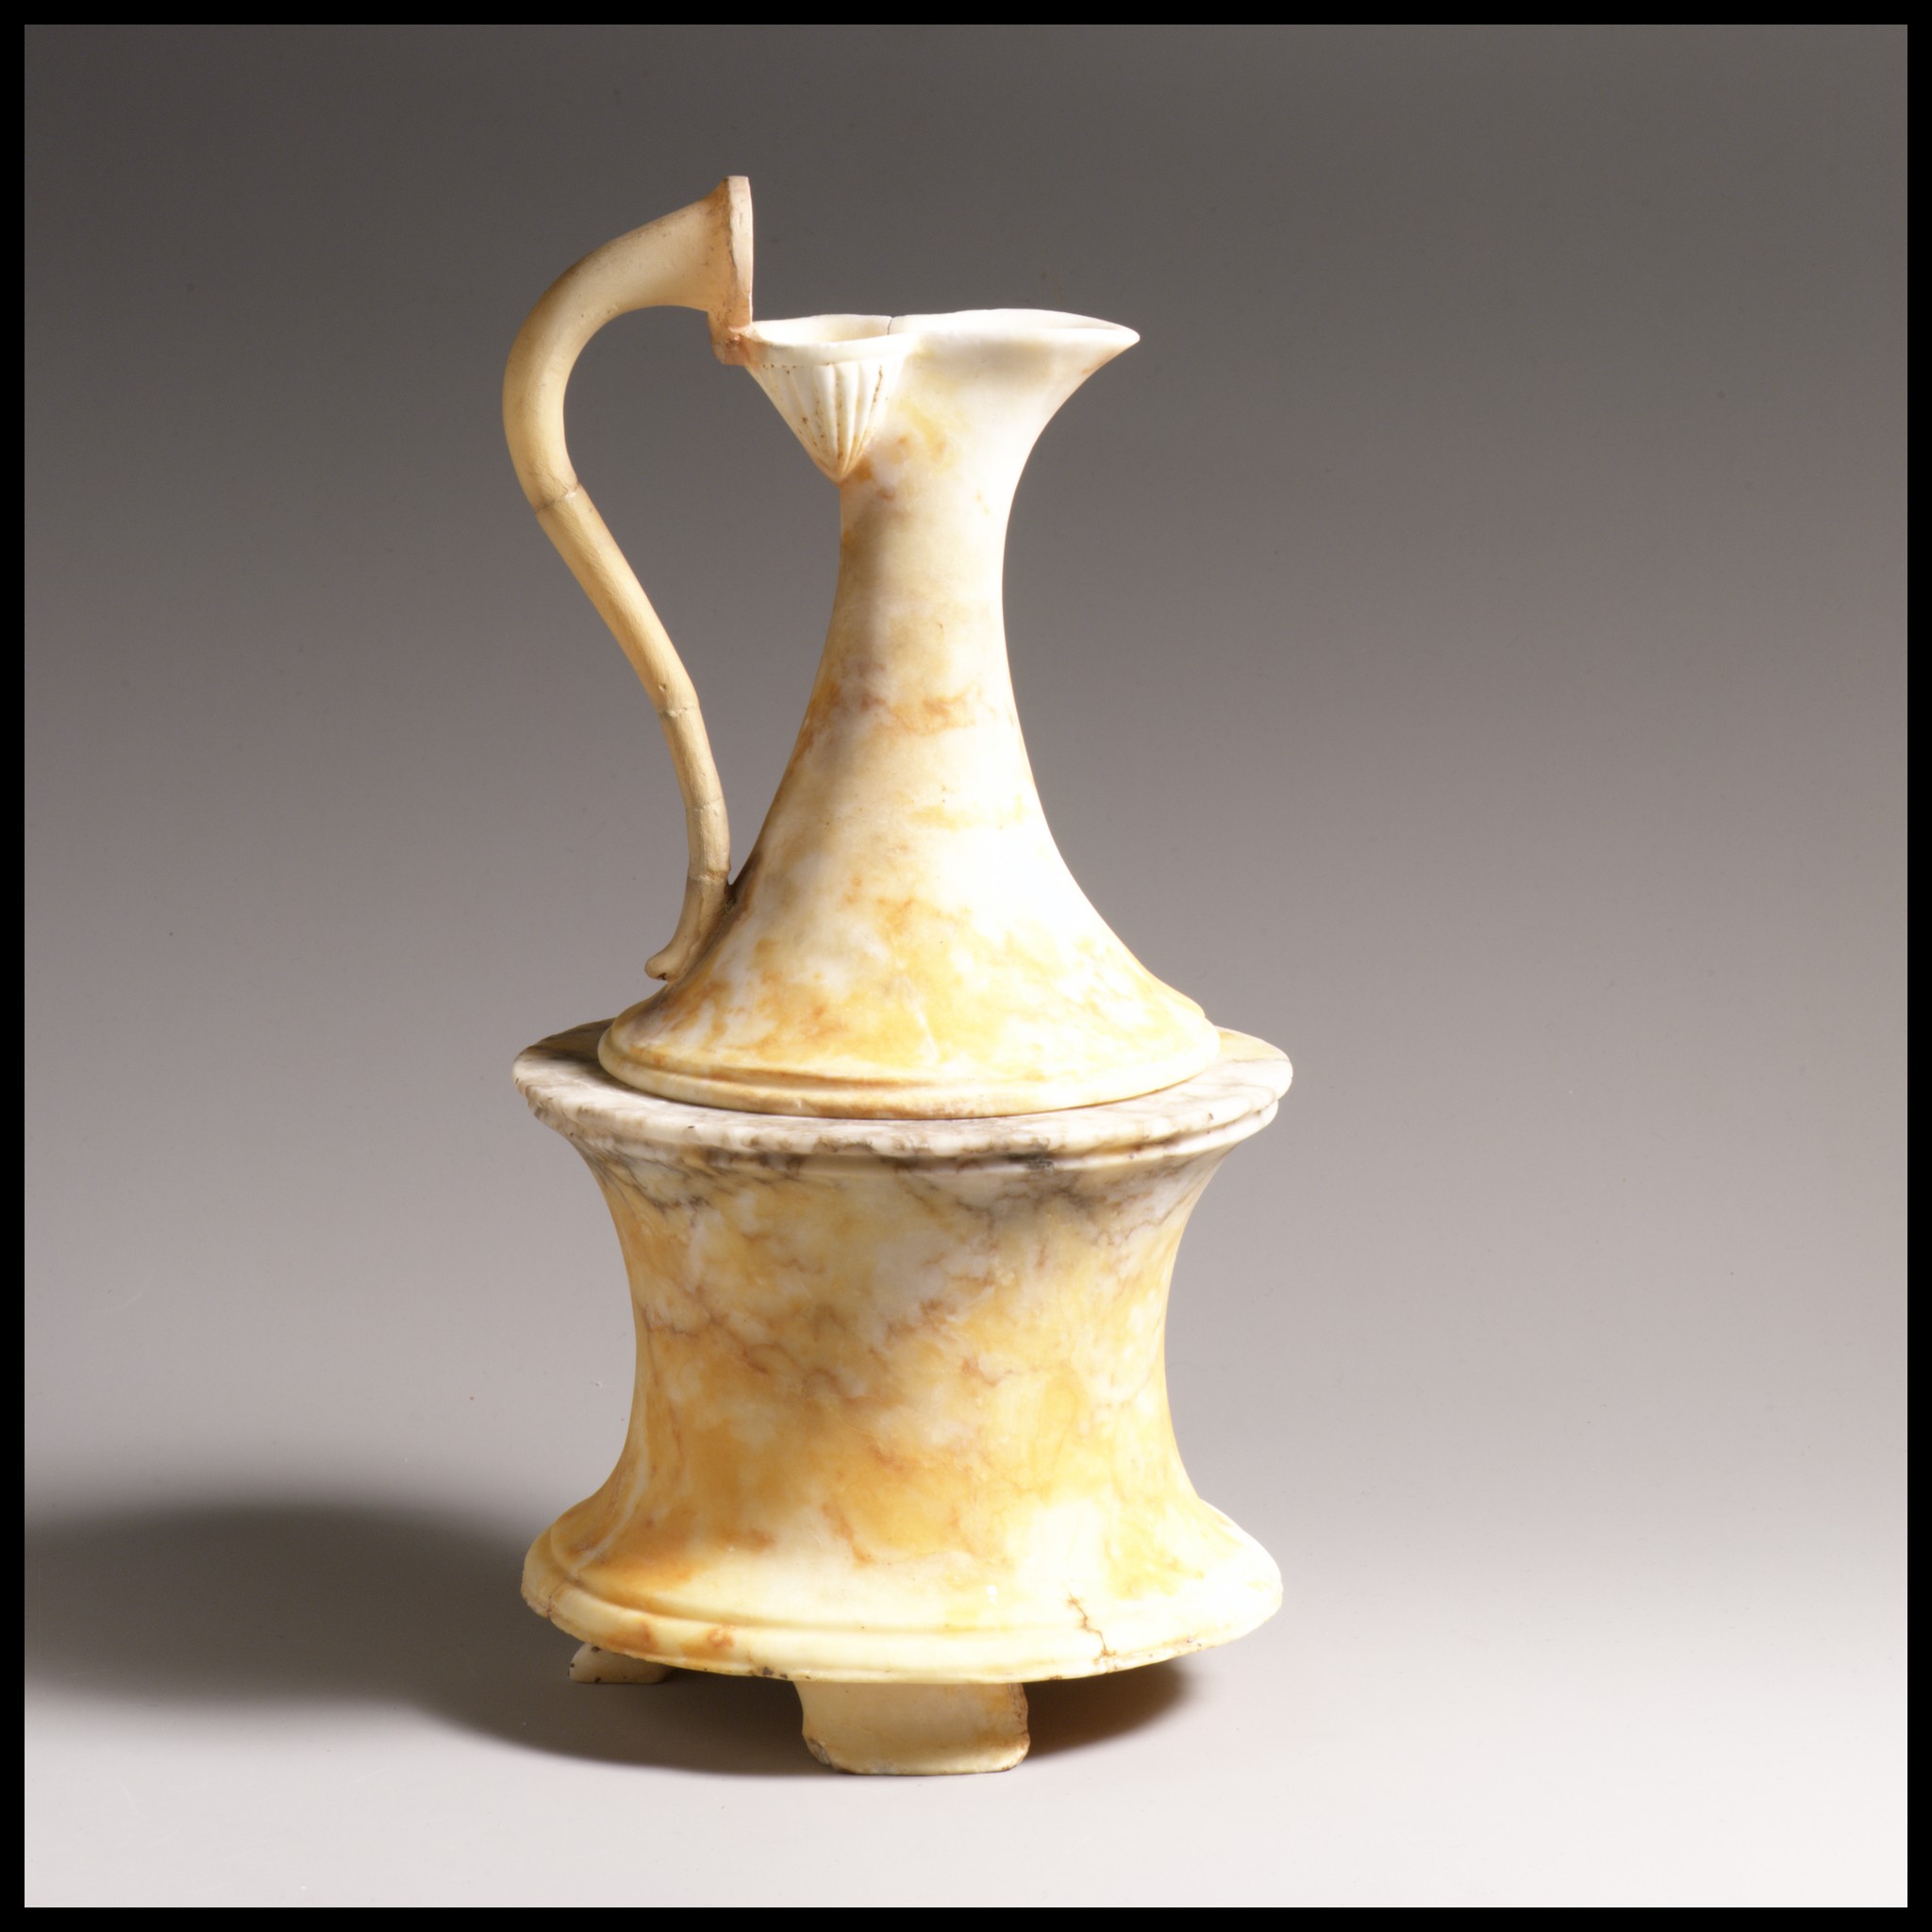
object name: vase in the form of a pyxis surmounted by an oinochoe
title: Marble vase in the form a of a pyxis (box) surmounted by an oinochoe (jug)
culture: greek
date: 400-201 BCE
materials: marble